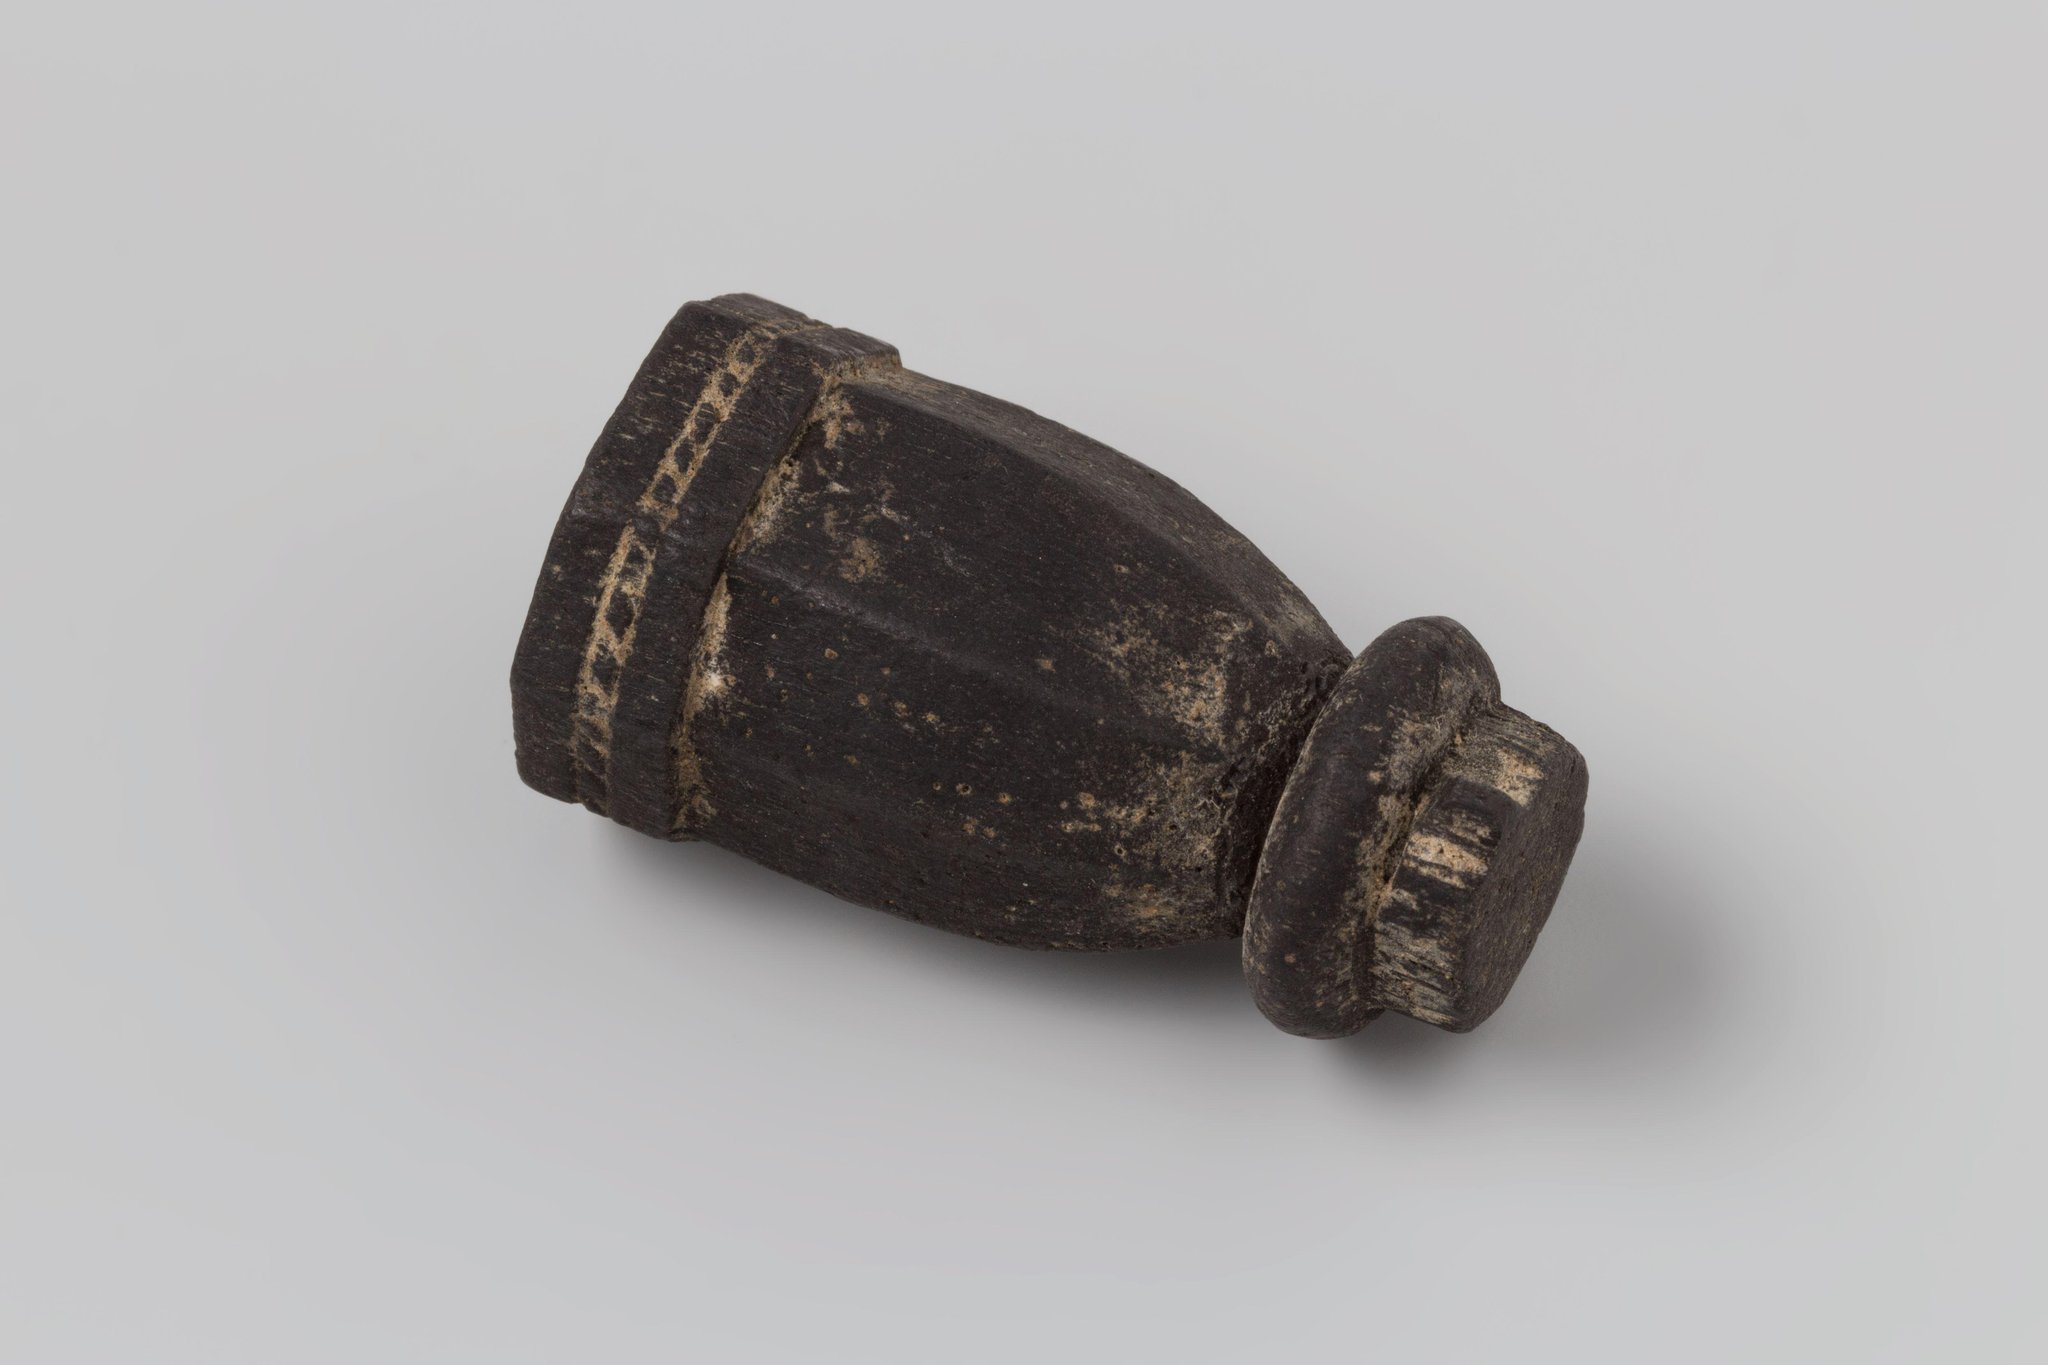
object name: object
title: Houten voorwerp uit V.O.C.-schip de 'Witte Leeuw'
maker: Anonymous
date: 1613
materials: wood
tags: verenigde oostindische compagnie, sint-helena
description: Houten voorwerp. Taps toelopende achtkantige vorm met aan de bovenzijde een rand met ingekerfde touw en aan de onderzijde een ring.